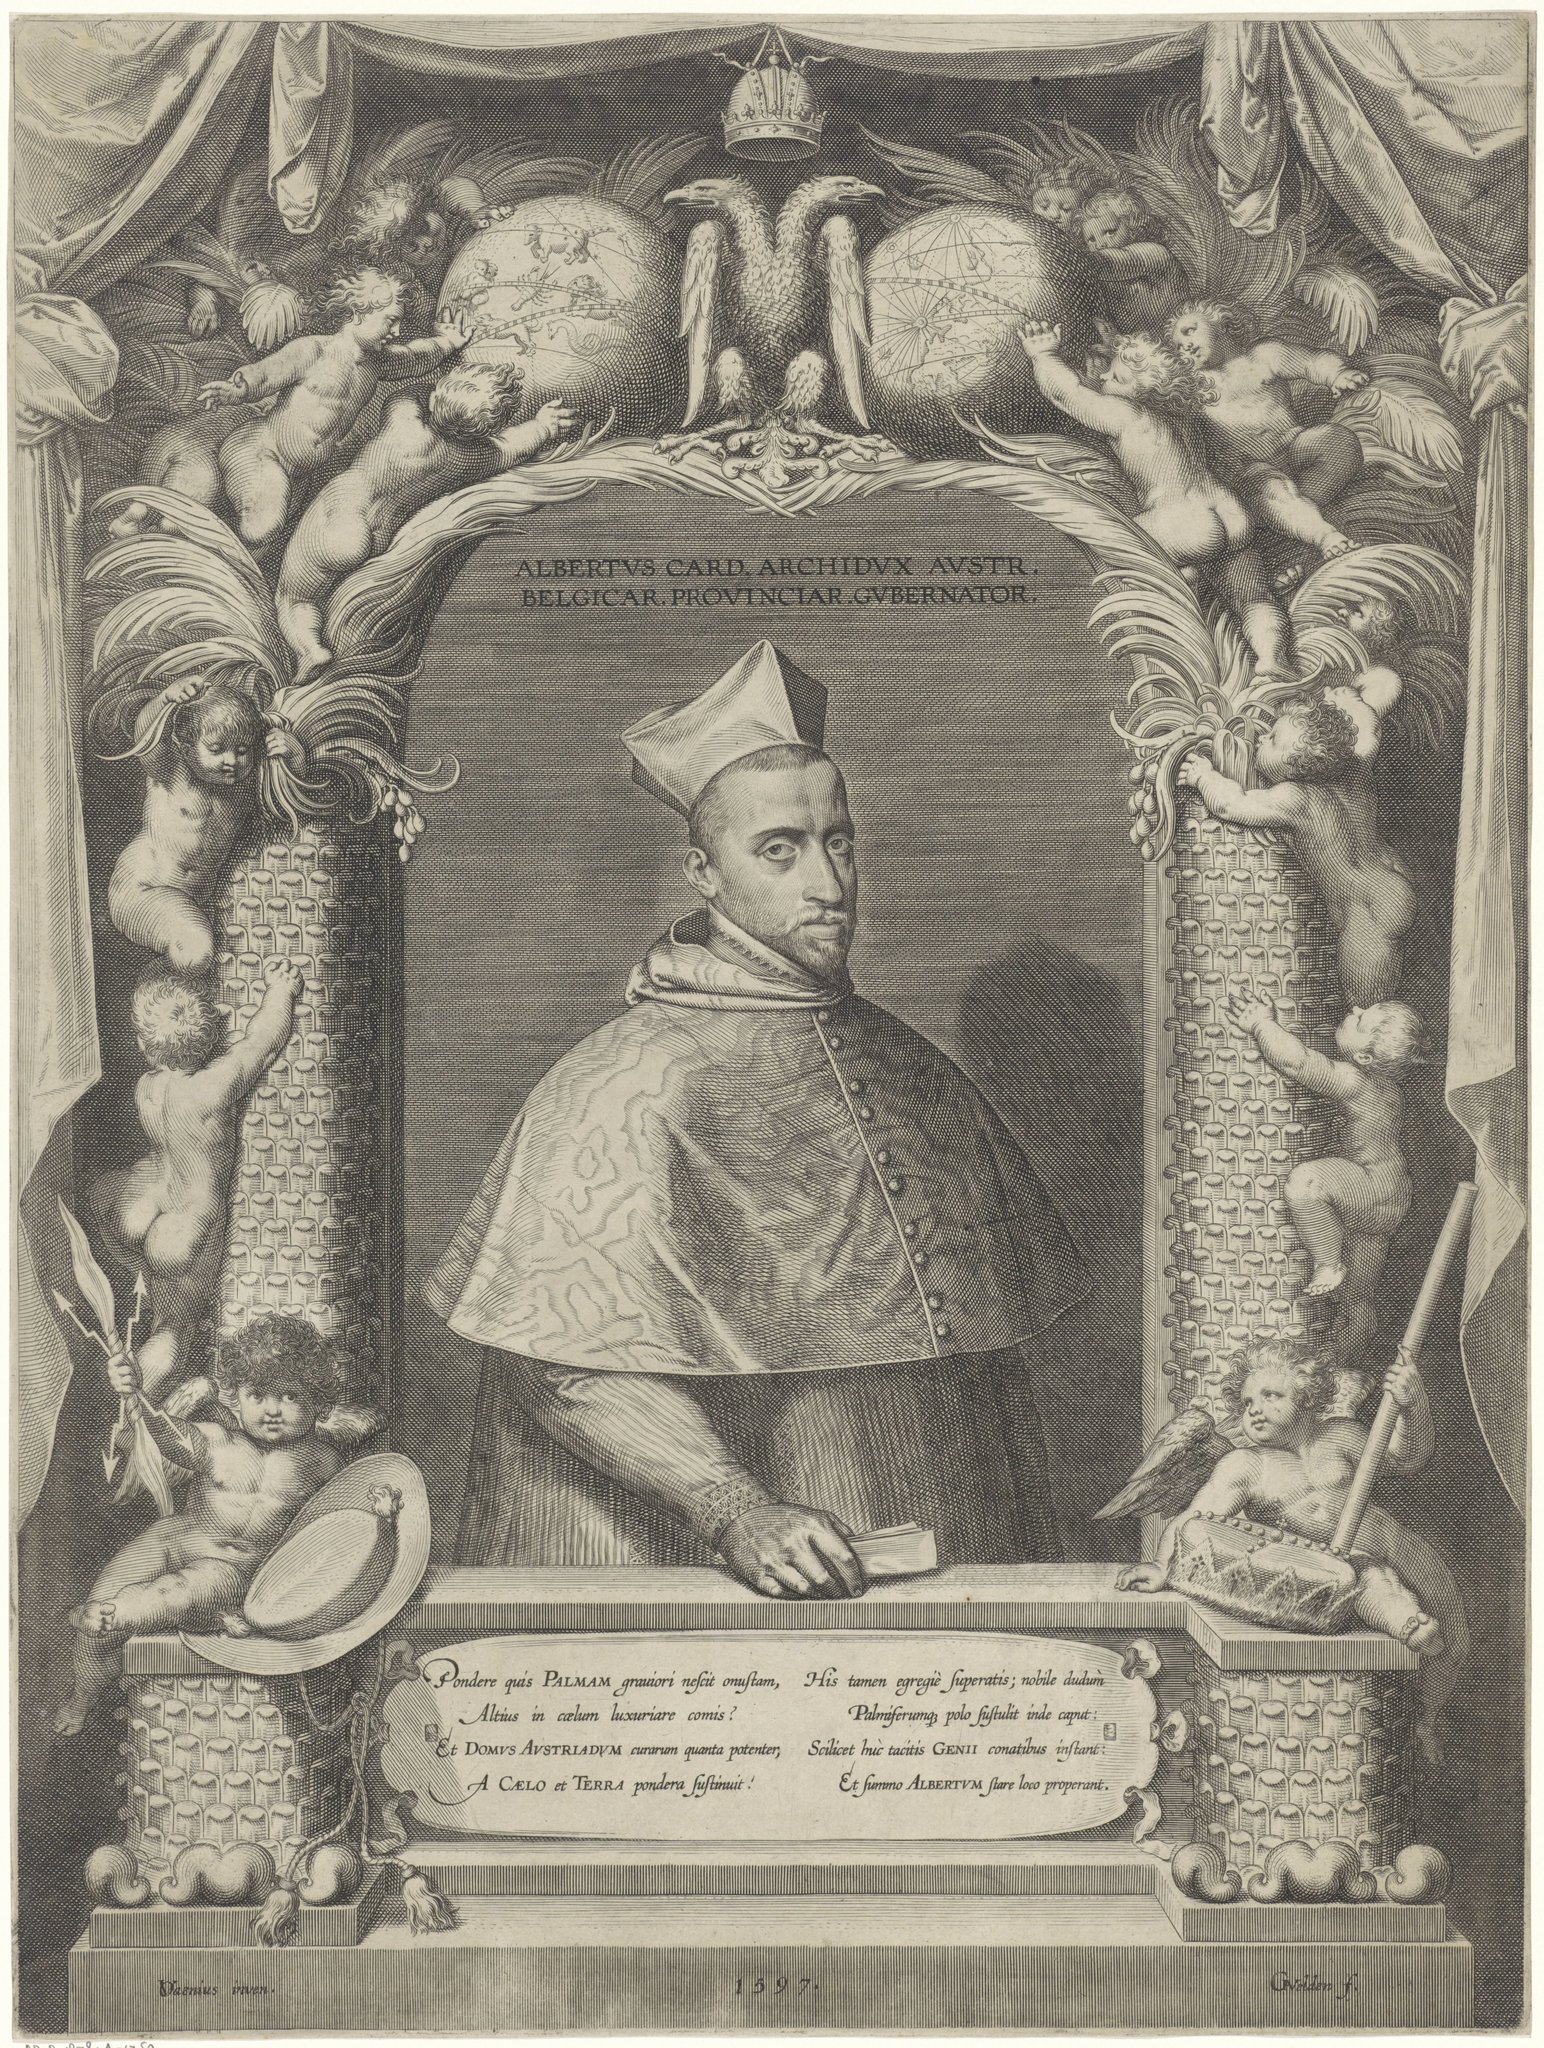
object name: print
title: Portret van Albrecht, aartshertog van Oostenrijk, in kardinaals gewaad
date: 1597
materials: paper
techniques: engraving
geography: antwerp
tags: brussels, albrecht aartshertog van oostenrijk, globe, cupids: 'amores', 'amoretti', 'putti', star-globe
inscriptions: collector's mark: Lugt 2228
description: Portret van Albrecht, aartshertog van Oostenrijk, in kardinaals gewaad. Om dit portret twee palmbomen met putti. Bovenaan een hemel- en een aardglobe en een tweekoppige adelaar.